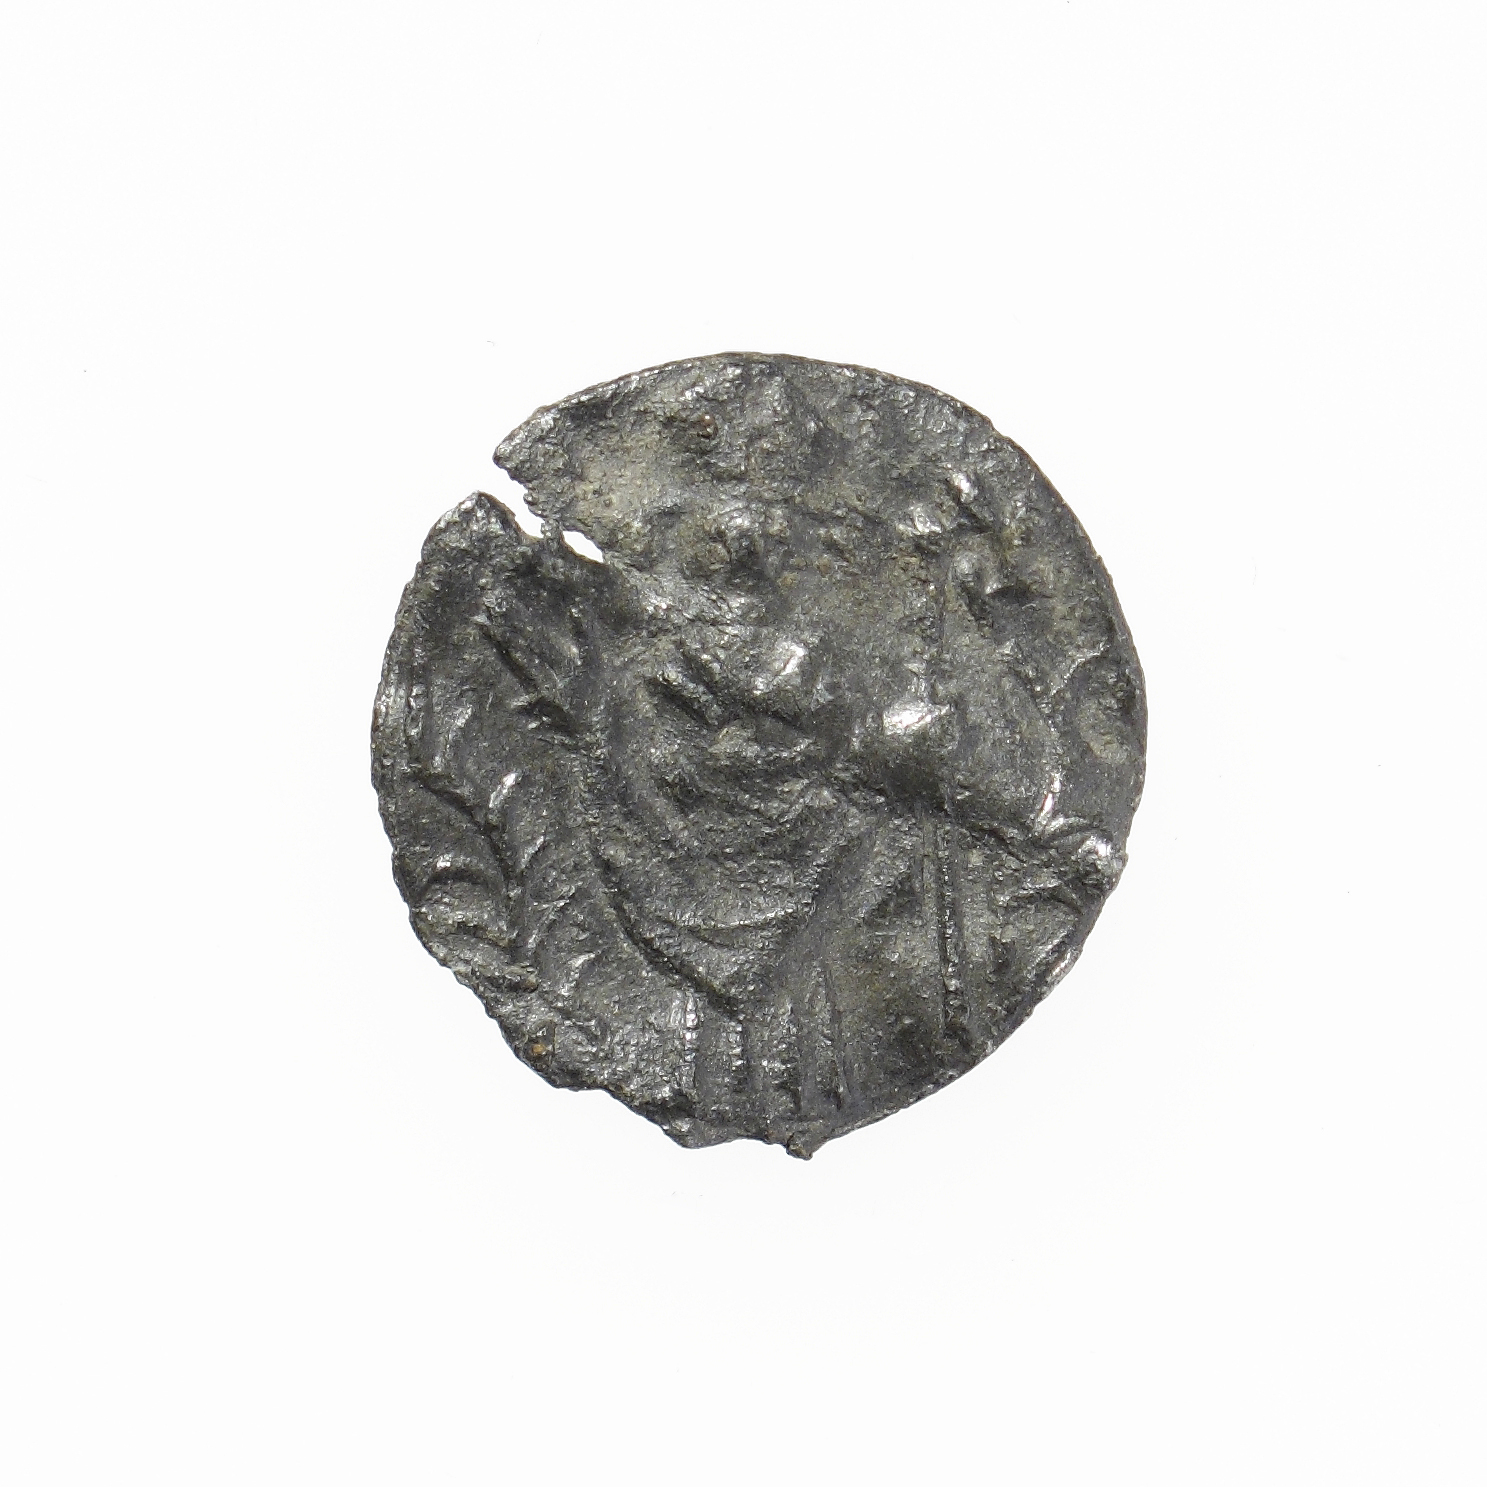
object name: pilgrim's badge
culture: french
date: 1301-1600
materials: lead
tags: saints